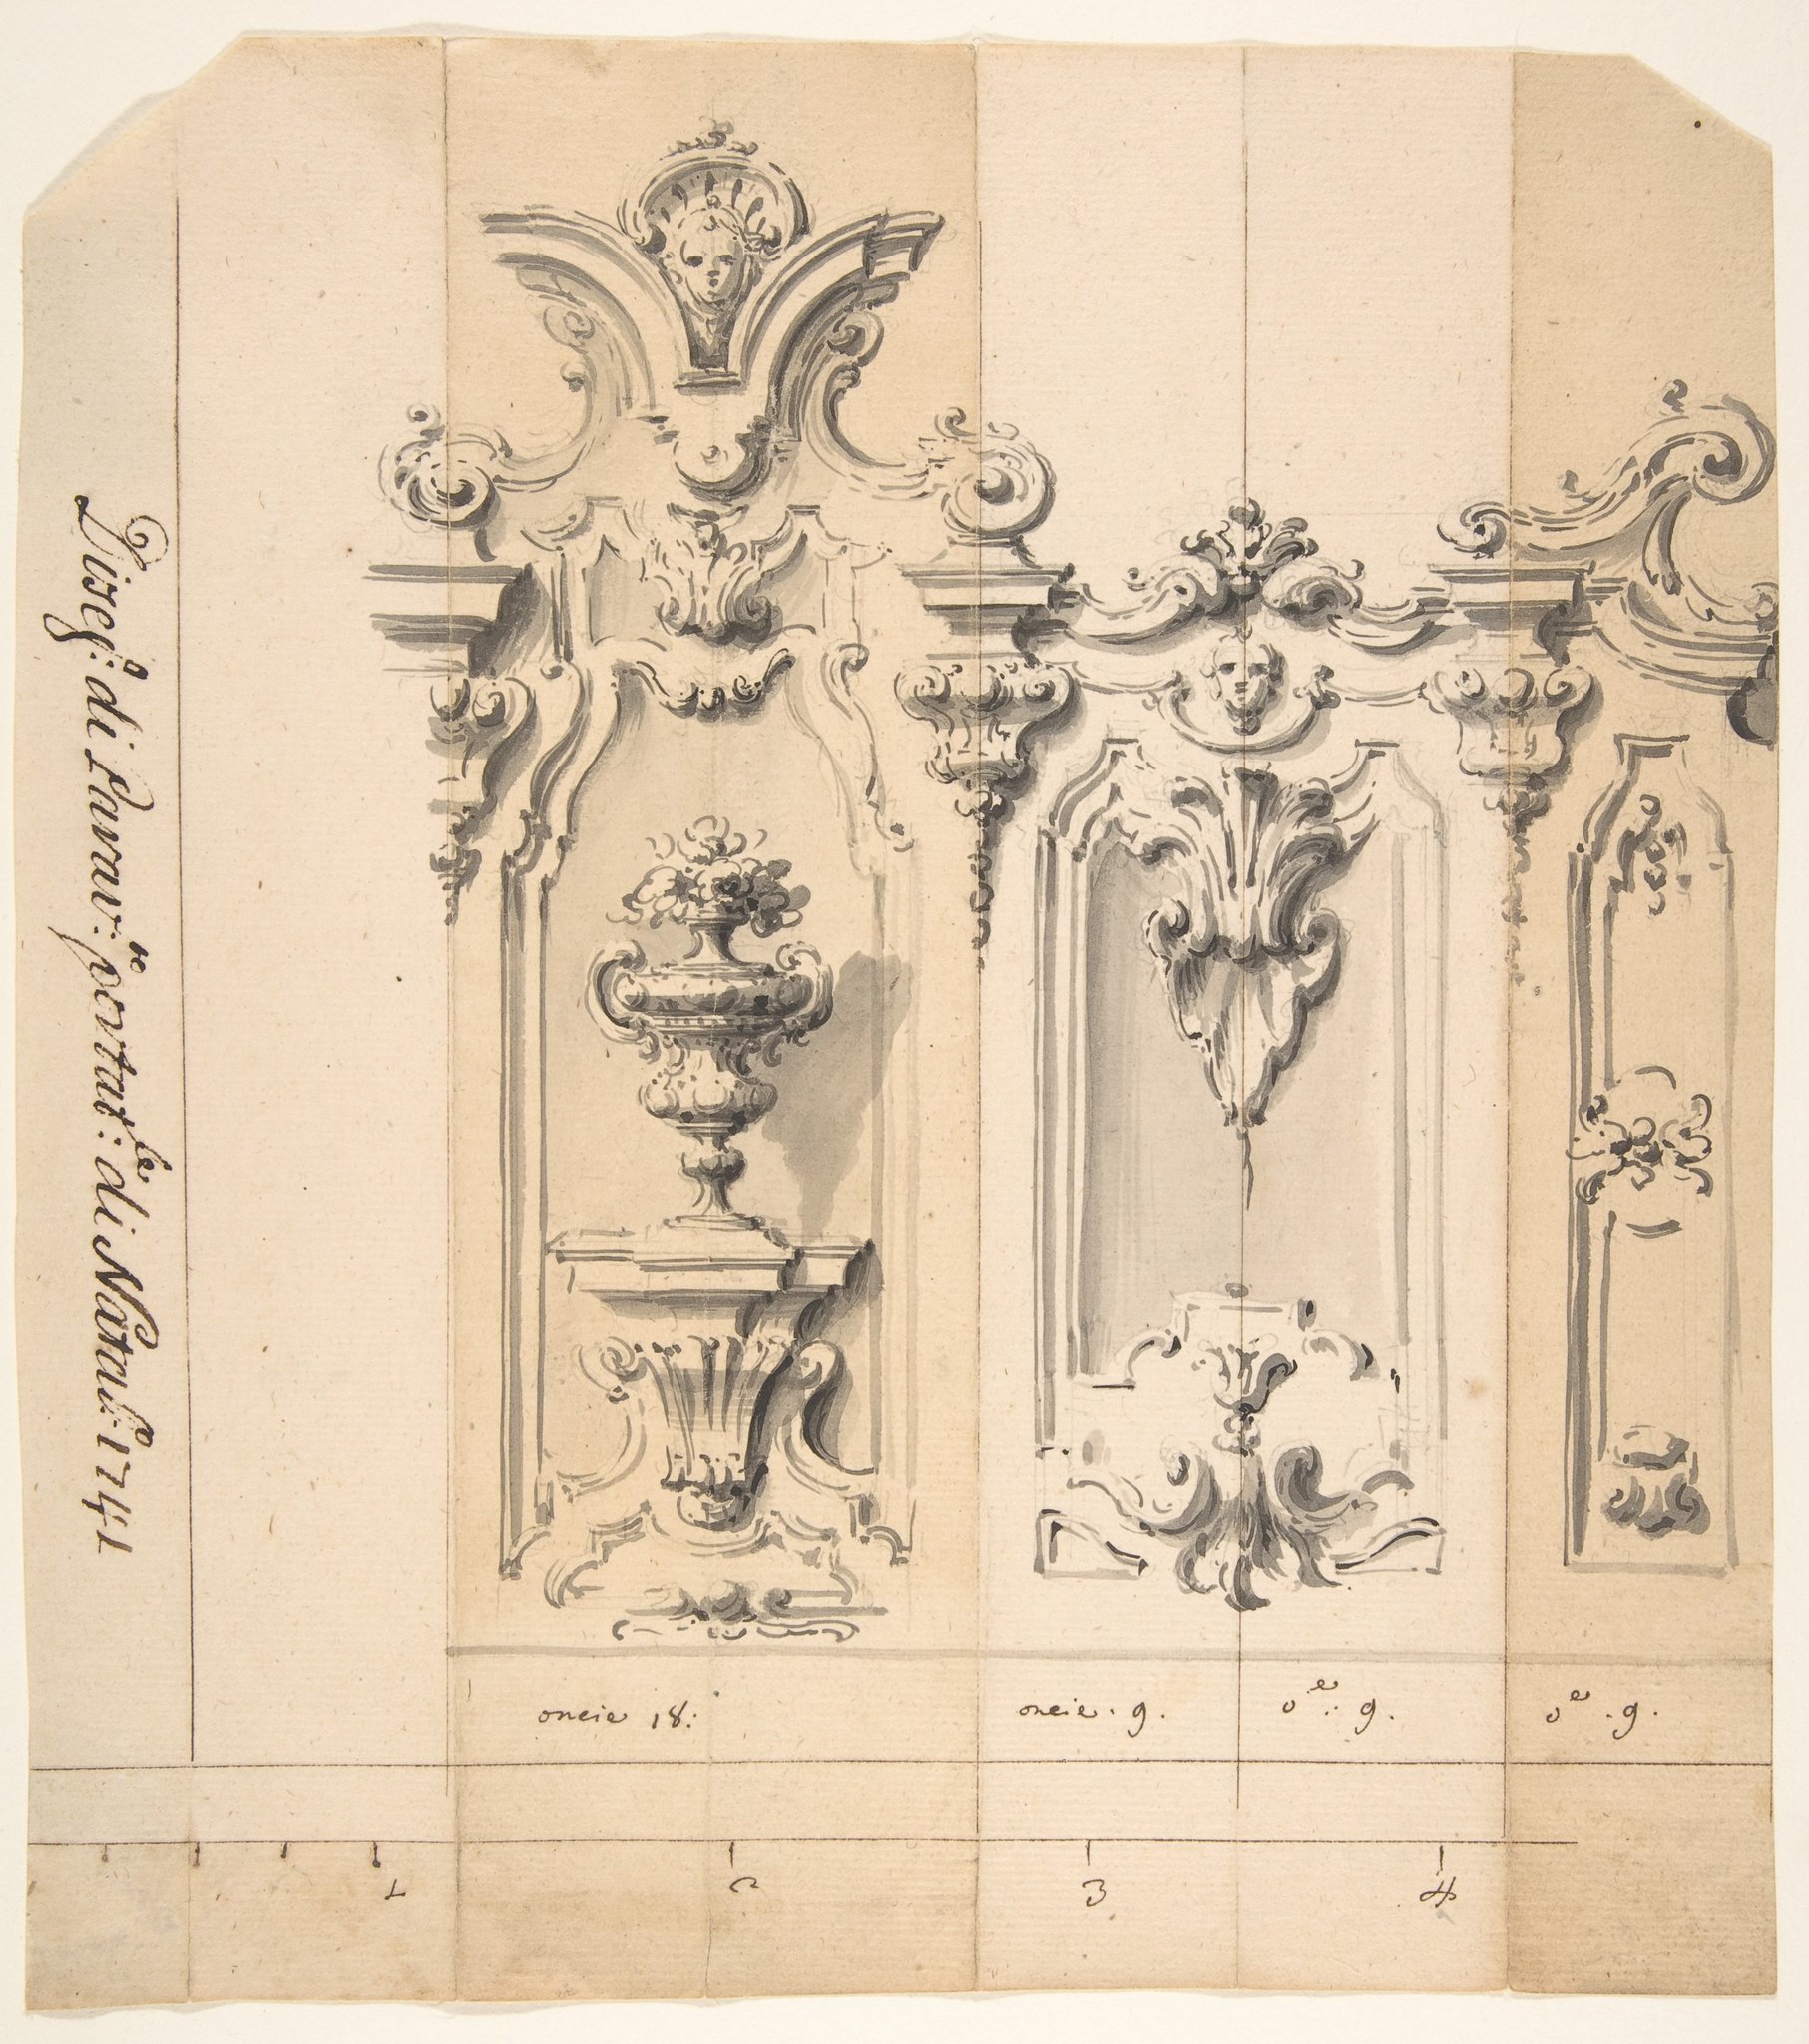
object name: drawing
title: Design for a Portable Screen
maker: giovanni battista natali iii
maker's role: artist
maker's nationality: italian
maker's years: 1698-1765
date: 1698-1765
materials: chalk, graphite, ink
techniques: brush, pen, wash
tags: screens,vases